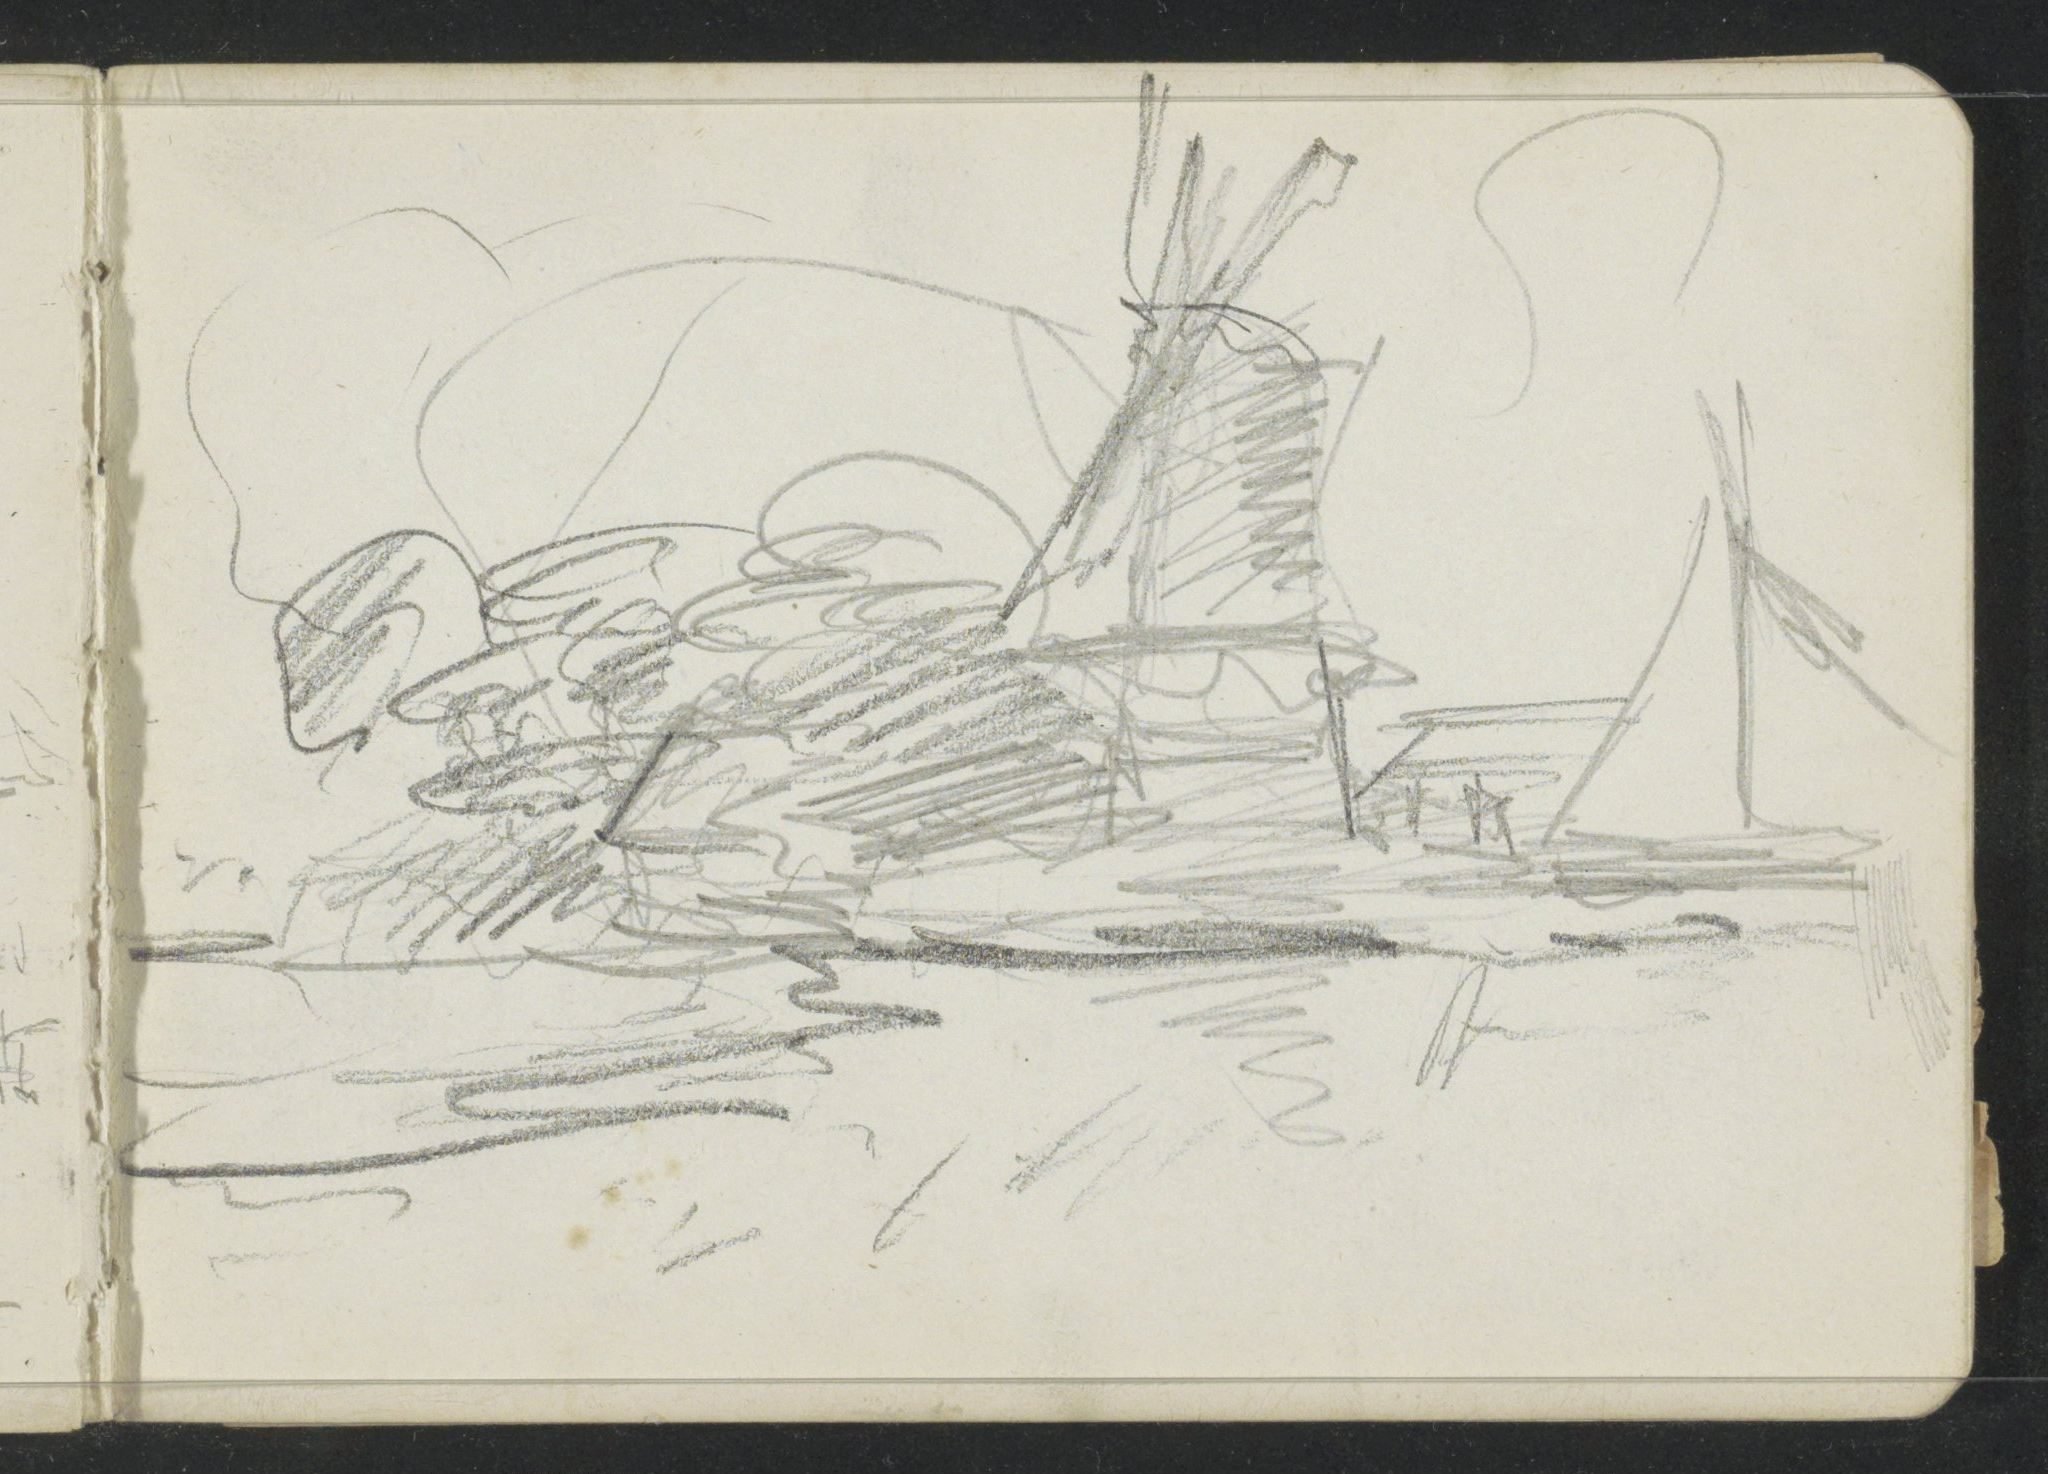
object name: sketchbook leaf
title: Landschap met een molen en een zeilboot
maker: johanna van de kamer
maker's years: 1873-1922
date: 1883-1922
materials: paper, pencil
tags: sailing-ship, sailing-boat, windmill in landscape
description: Blad 21 recto uit een schetsboek met 27 bladen.